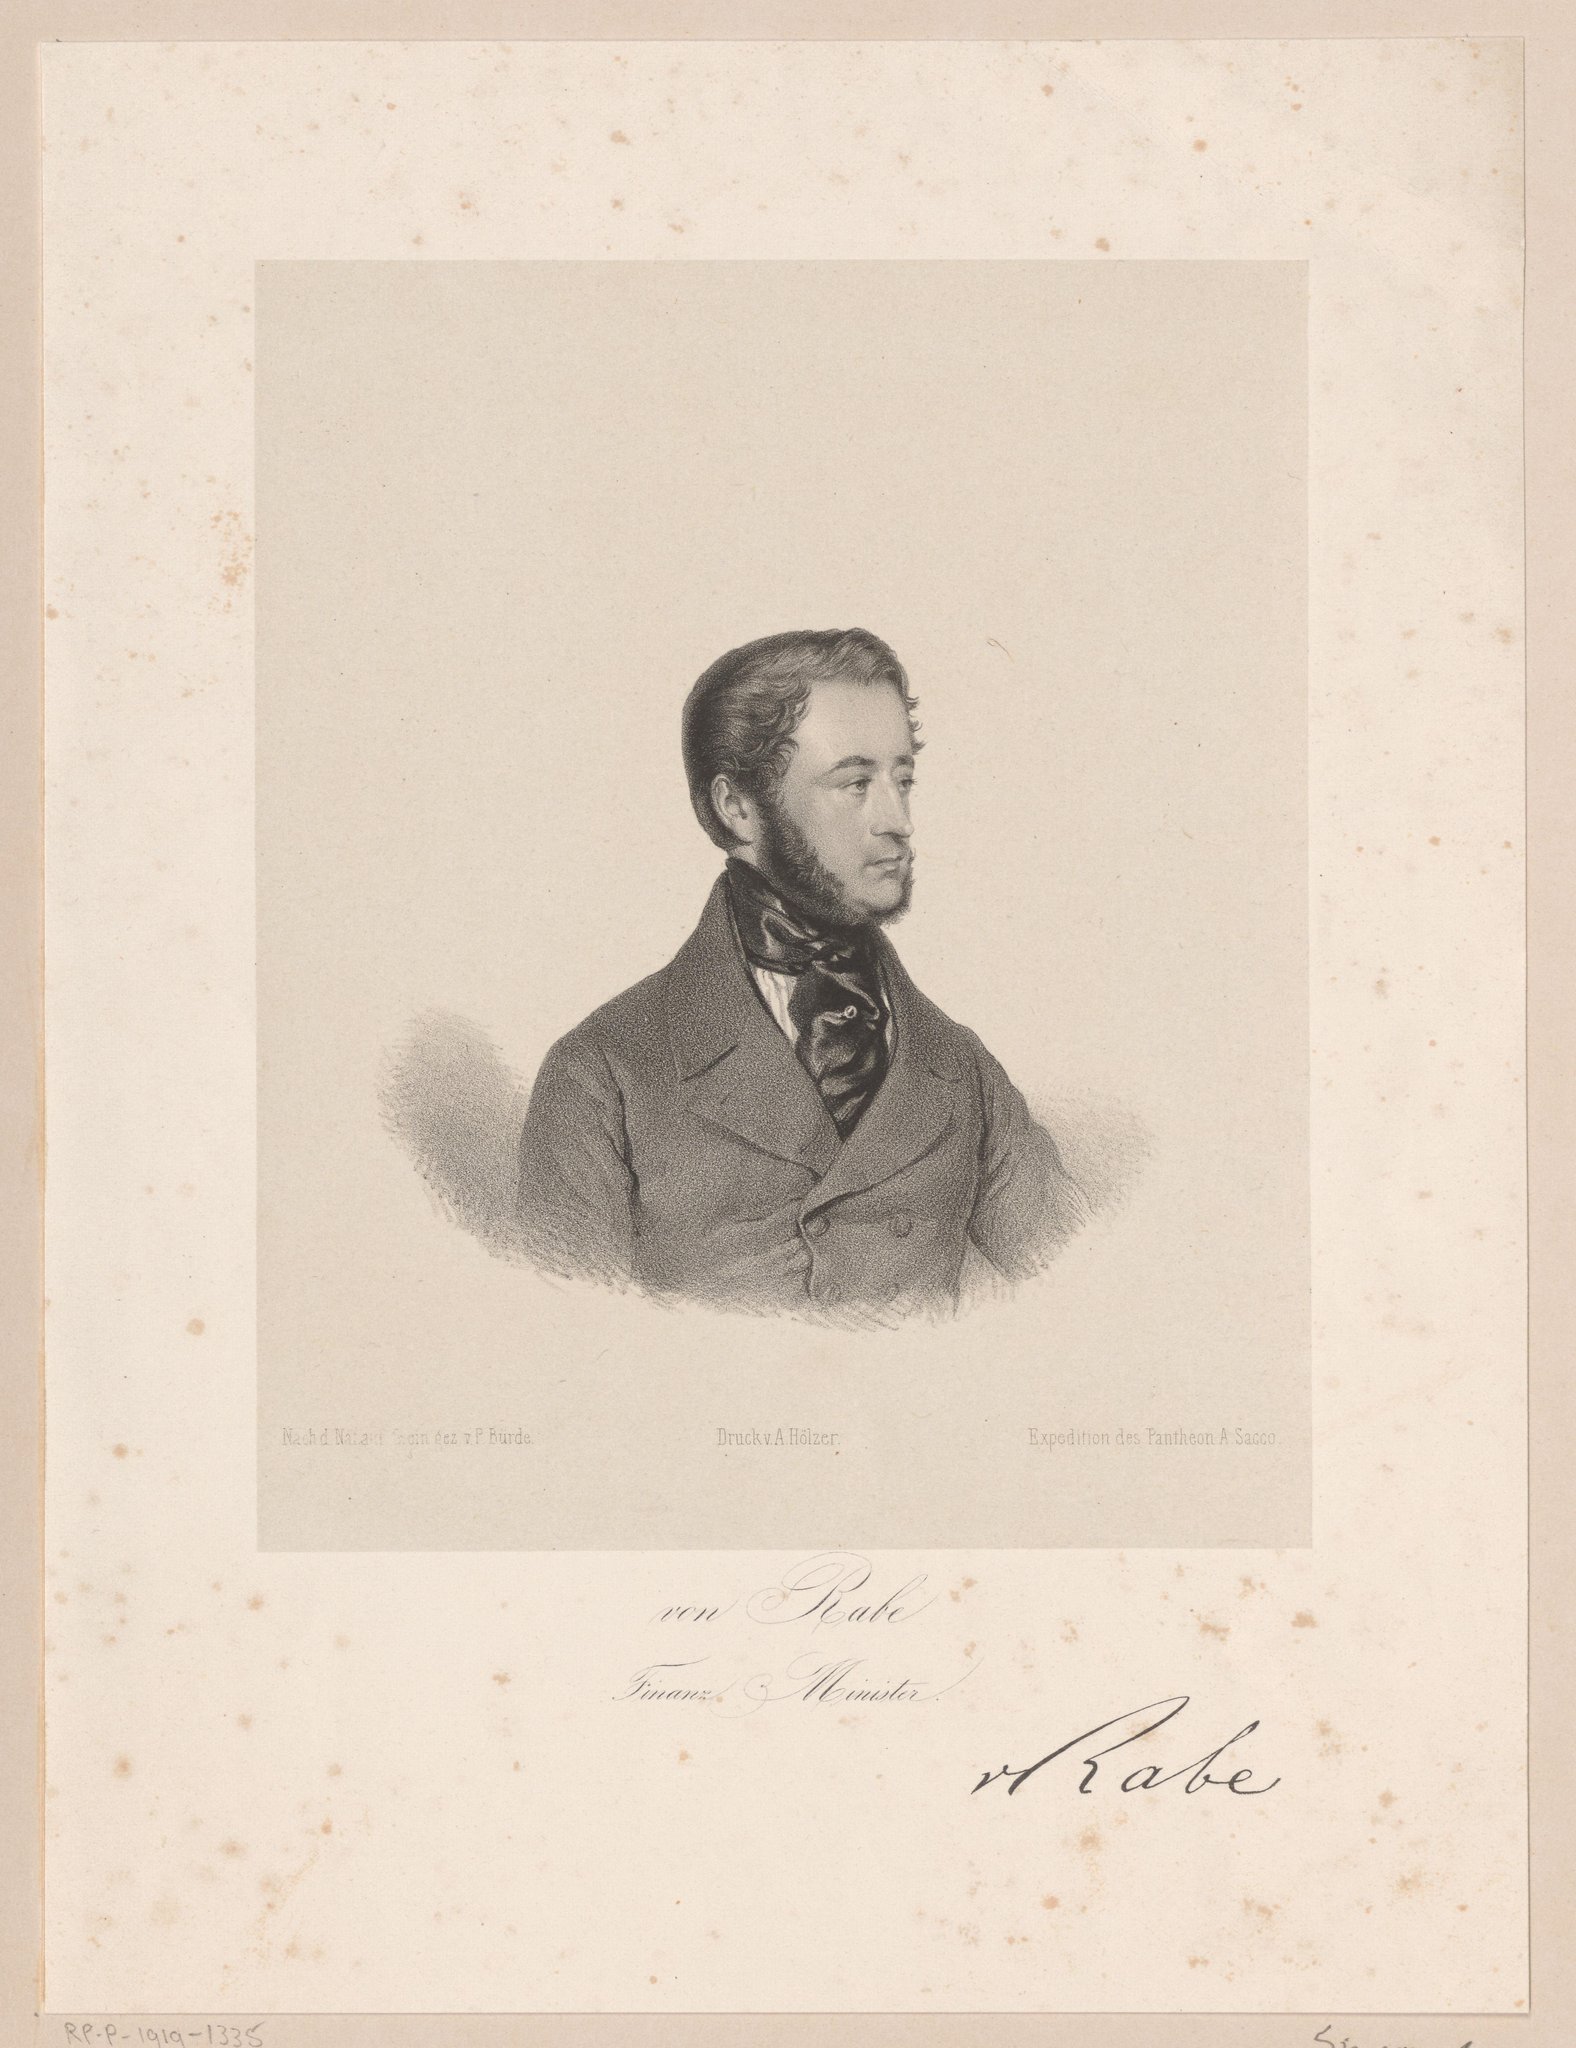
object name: print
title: Expedition des Pantheon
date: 1829-1863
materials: paper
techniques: lithograph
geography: berlin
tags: historical persons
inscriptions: collector's mark: Lugt 2228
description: Onder het portret een facsimile van de handtekening van de geportretteerde.